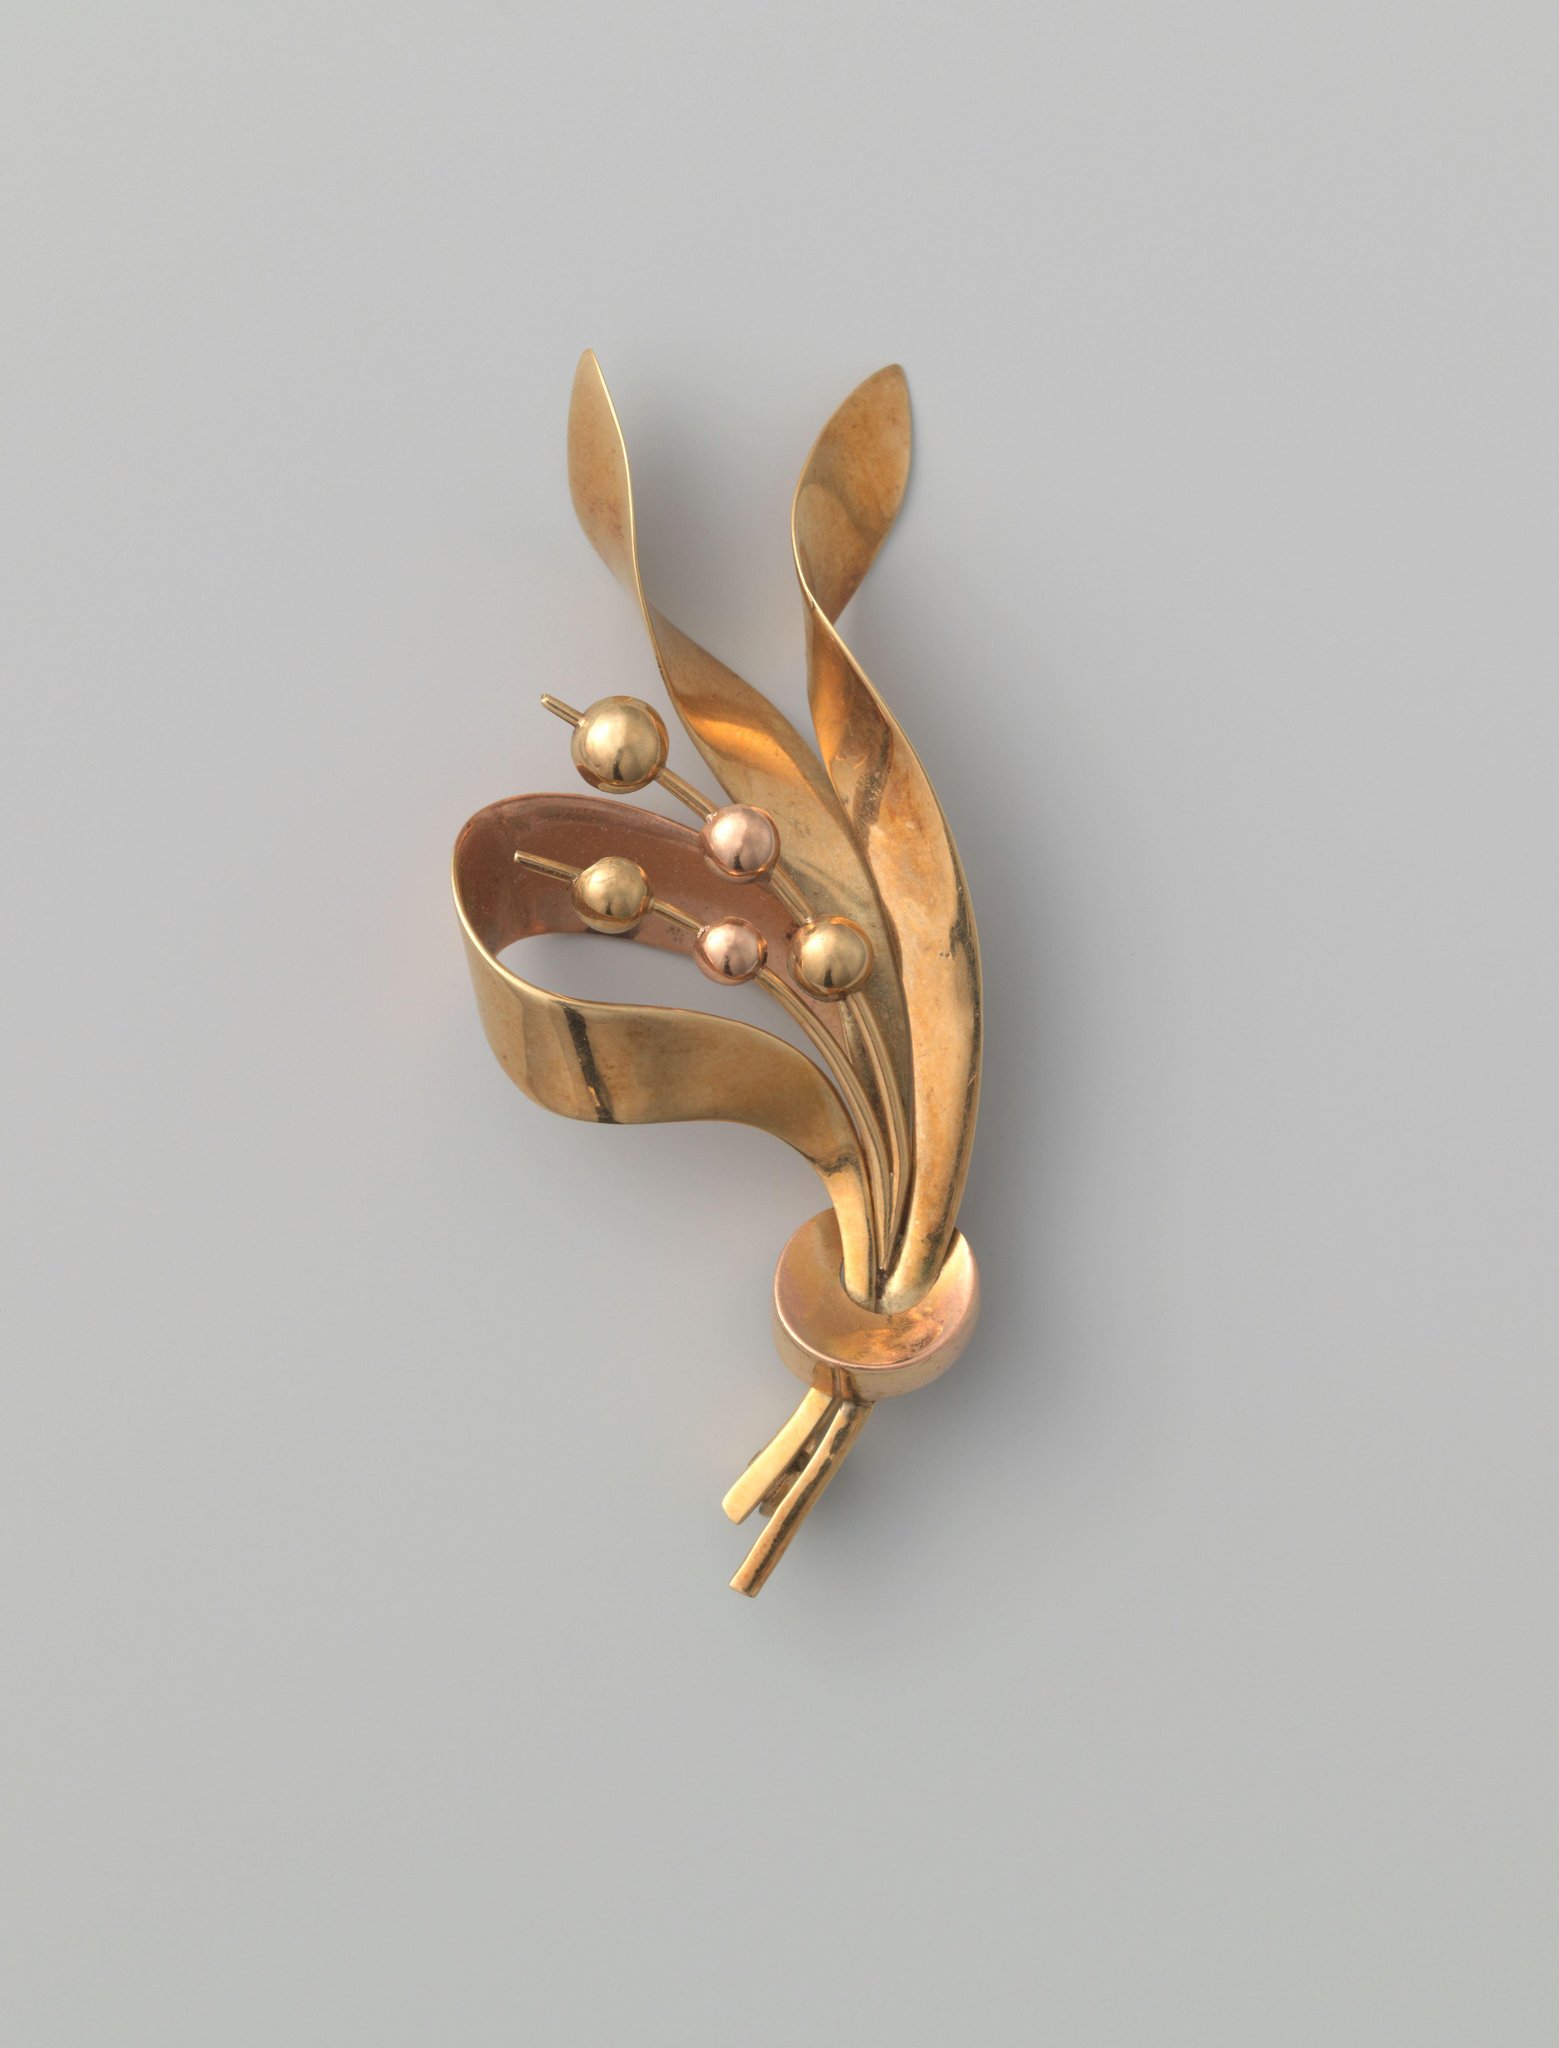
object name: brooch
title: Flower Brooch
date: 1947-1953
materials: gold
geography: netherlands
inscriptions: maker's mark: ‘4RC’, alloy mark: ‘(oud) eikenblad’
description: Takbroche van goud in twee kleuren (rood en geel) met vijf halve bollen (twee in rood) op gouddraad gemonteerd.